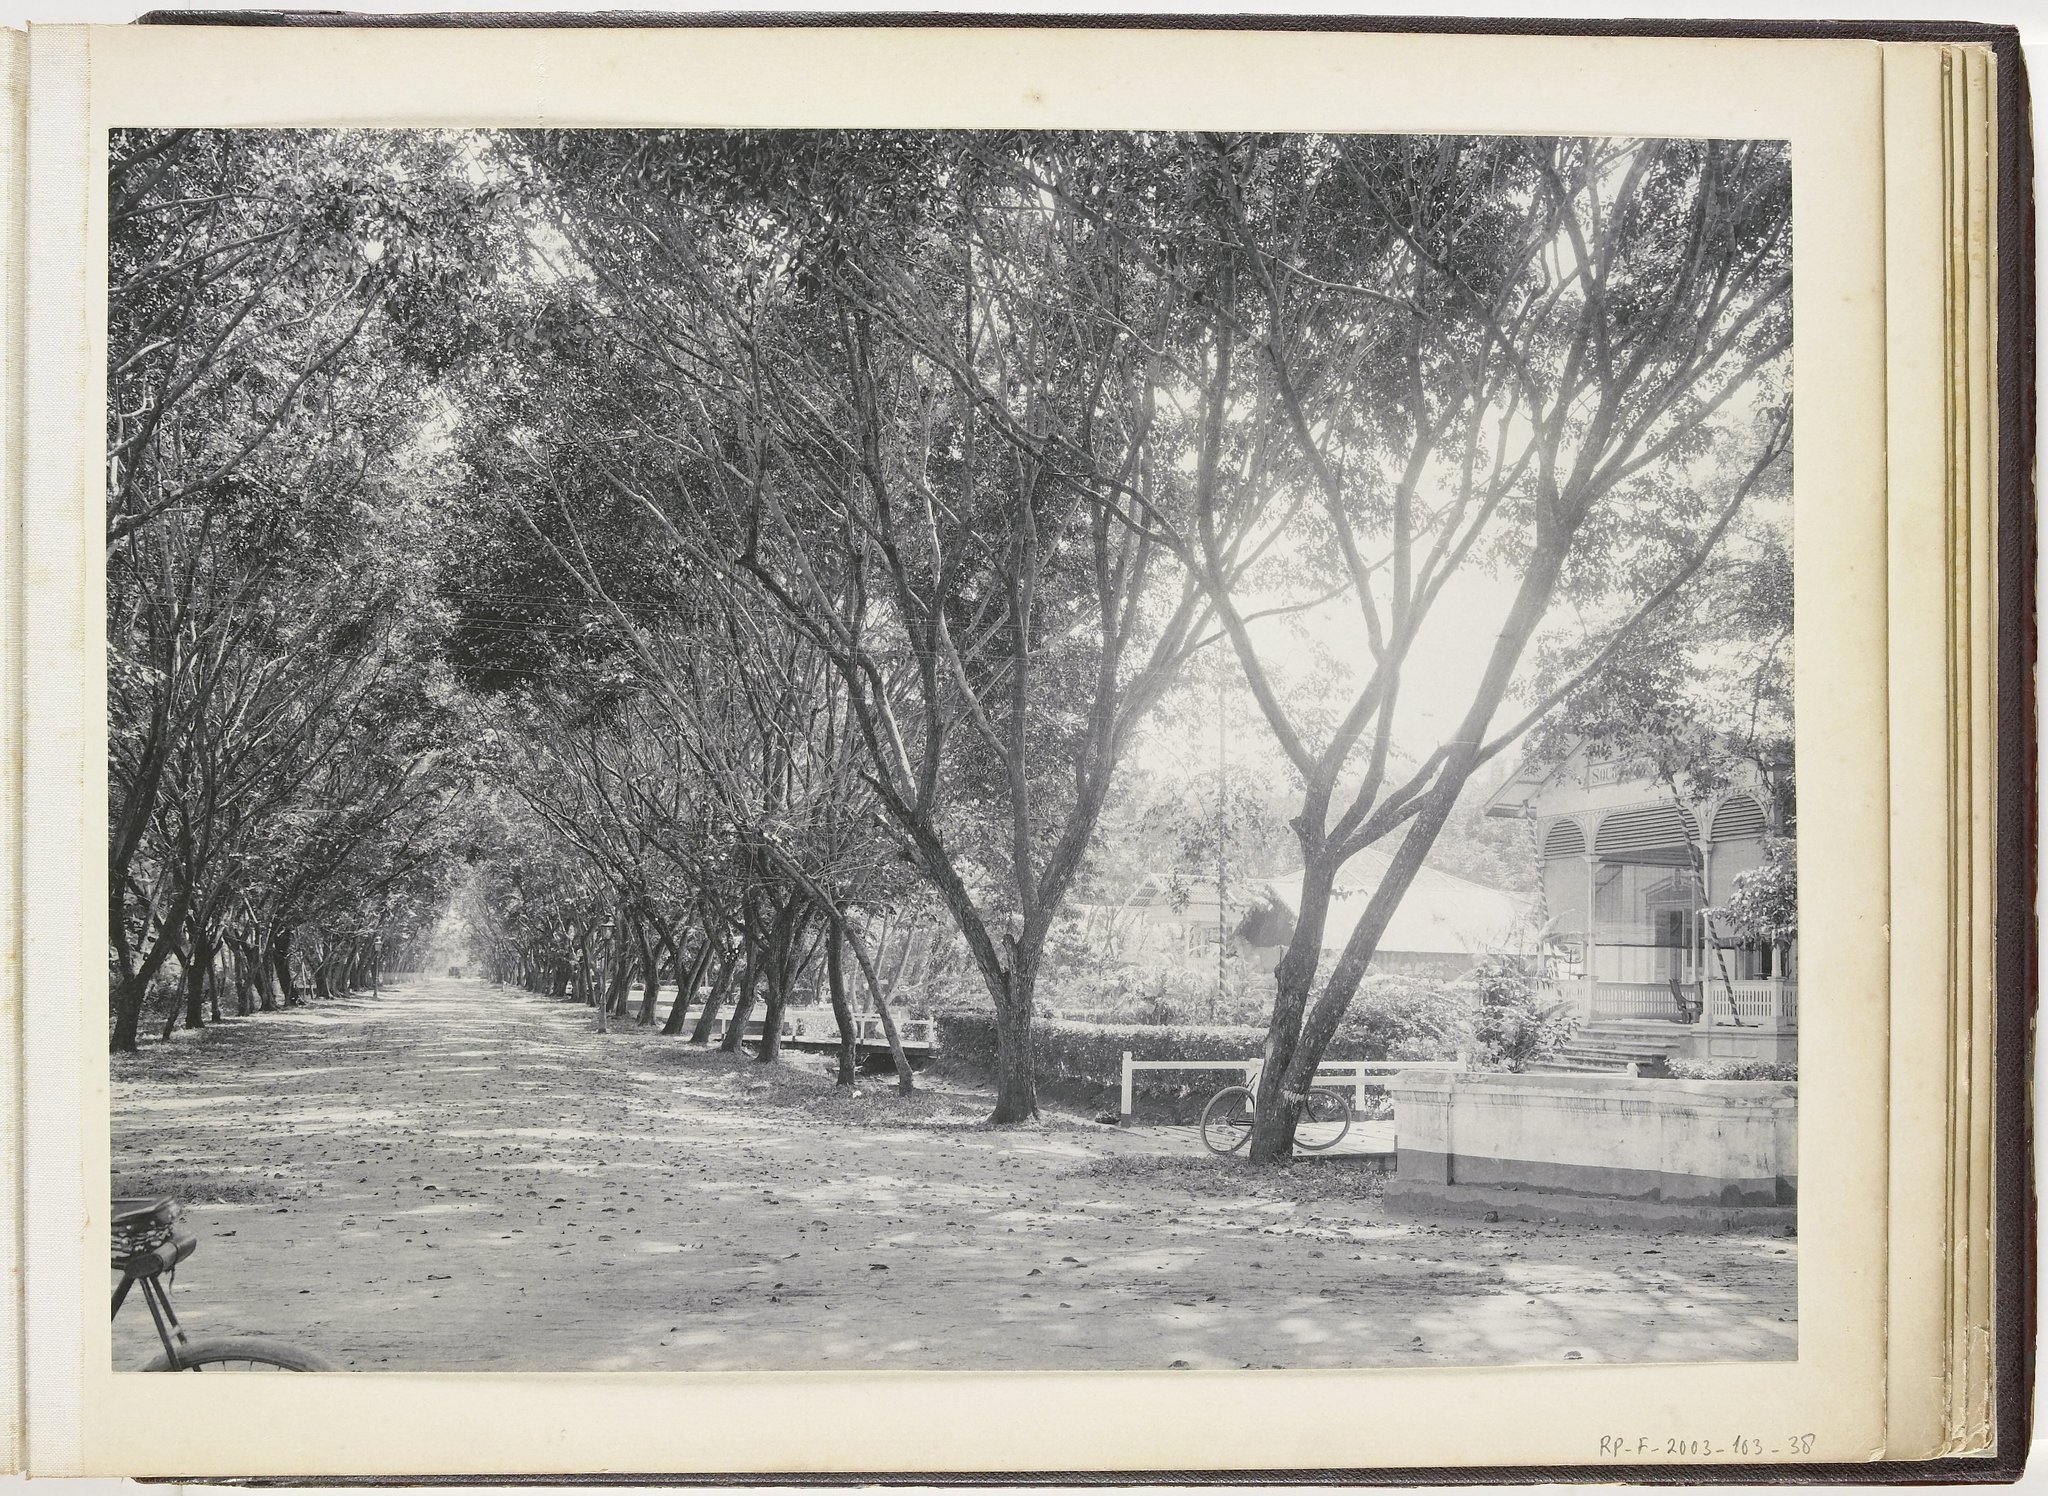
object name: photograph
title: Gezicht in de Sennah Allee met Sociëteit Klambir, Langkat Sumatra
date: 1900-1905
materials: cardboard, paper, photographic support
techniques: platinum process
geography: bindjai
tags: sumatra